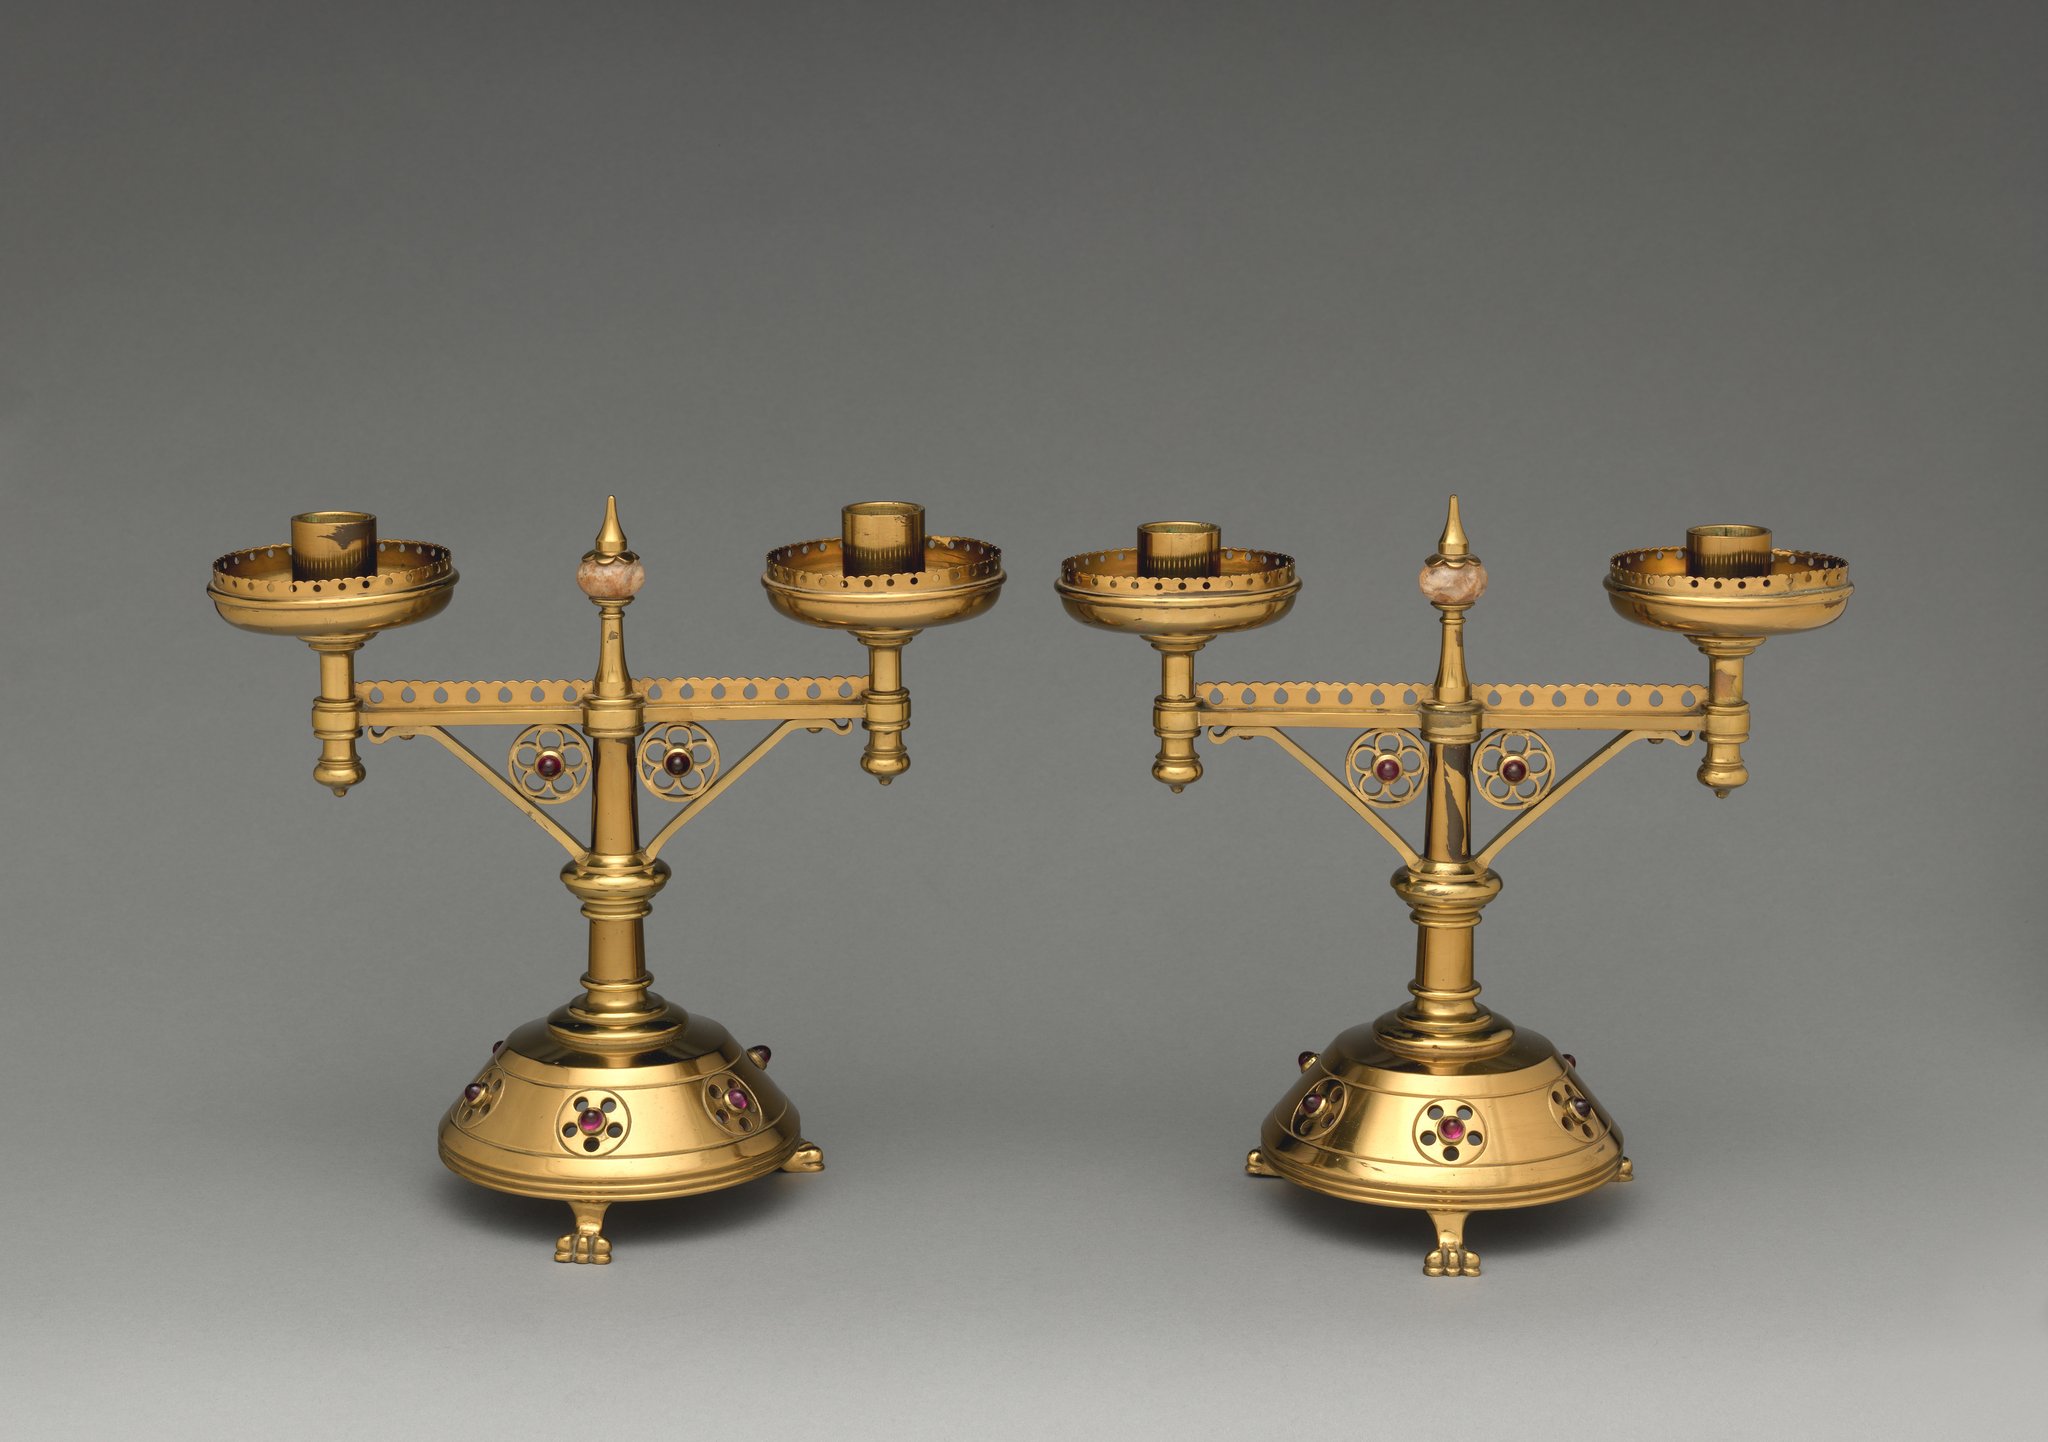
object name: candlestick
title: Candlestick (one of a pair)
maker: bruce j. talbert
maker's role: designer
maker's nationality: british, scottish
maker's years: 1838-1881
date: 1870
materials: brass, quartz